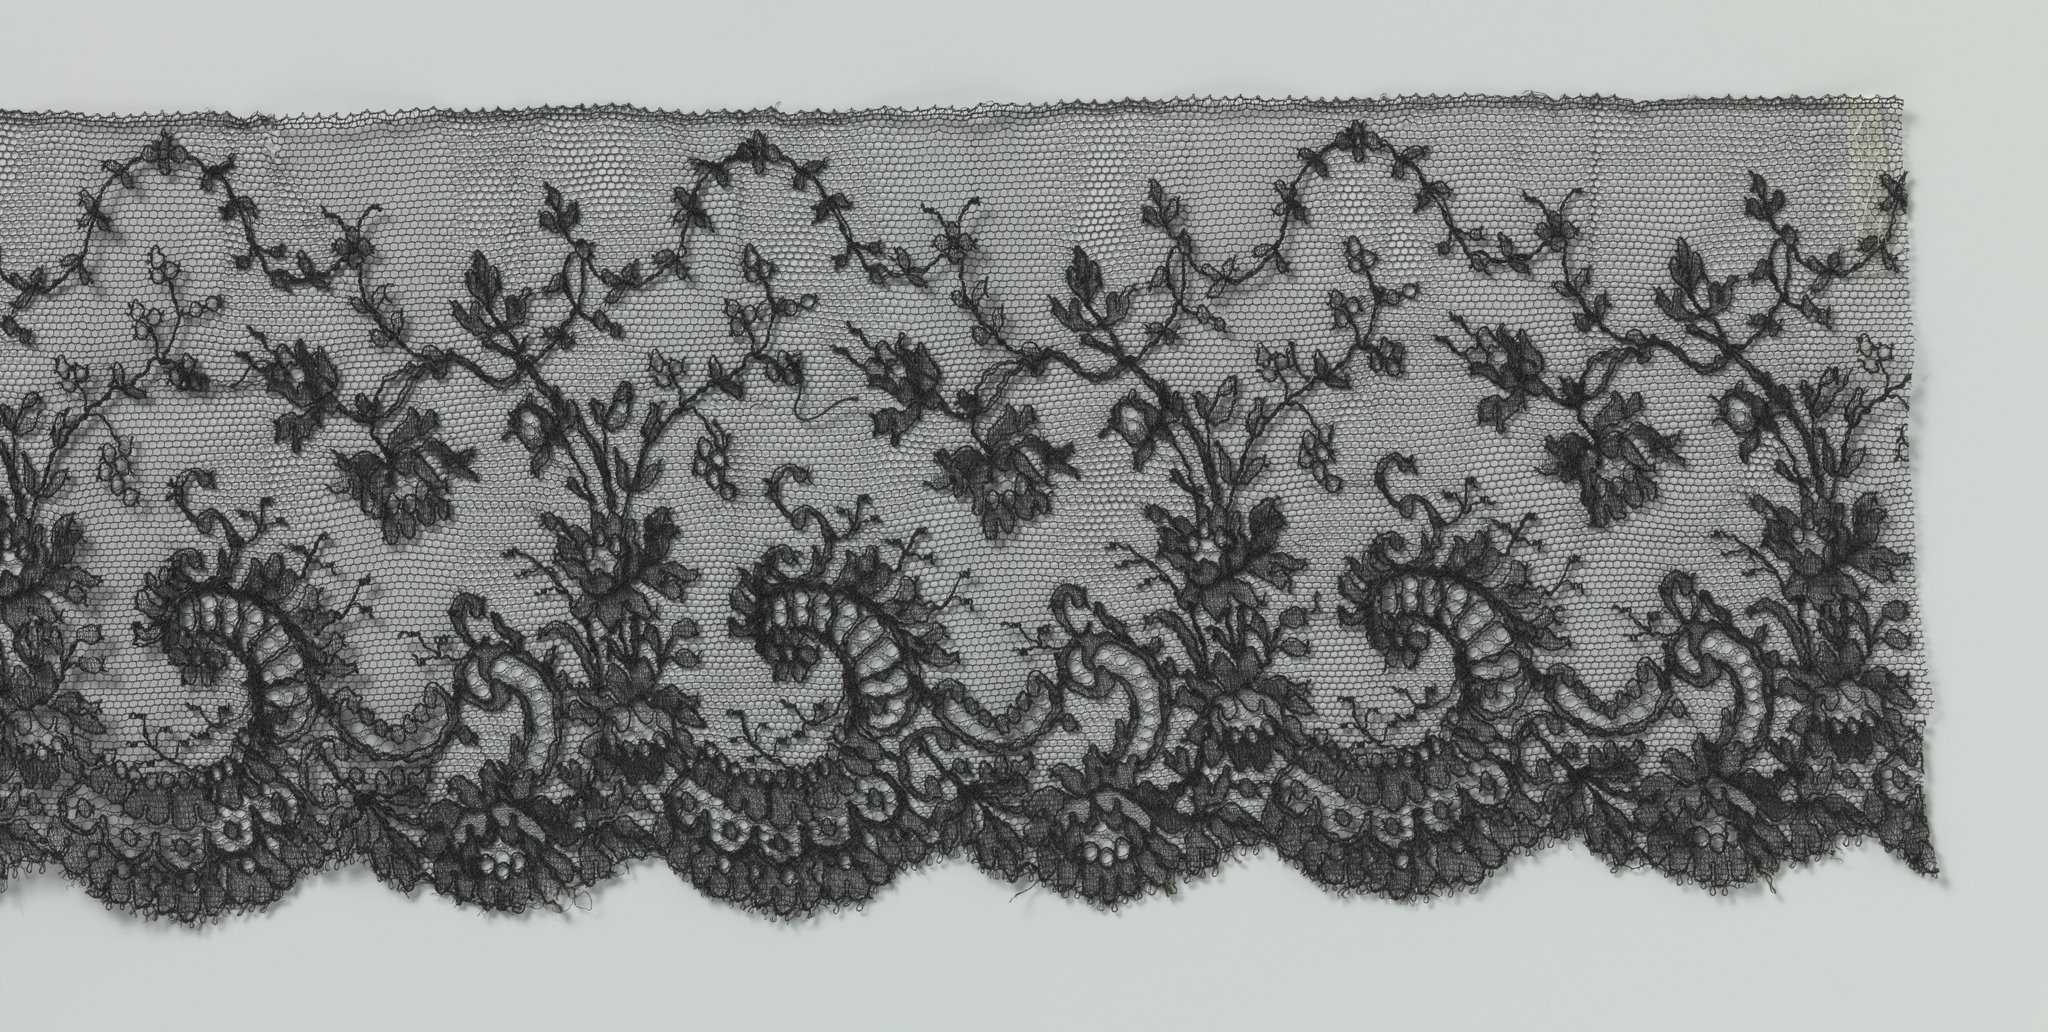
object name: strip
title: Strook machinale kant met rozentakken tussen c-voluten langs de onderzijde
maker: Anonymous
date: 1885-1899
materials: cotton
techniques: lace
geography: calais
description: Strook machinale kant: machinale Chantilly-kant. Het zich herhalende patroon langs de onderzijde van de strook bestaat uit c-voluten waartussen rozentakken ontspringen. De takken oversnijden deels een ijle bladslinger die zich langs de bovenzijde van de strook beweegt met boogjes en lussen. De motieven zijn voorzien van contourdraden en zijn met elkaar verbonden door een machinale tulegrond. In de motieven zijn siergronden toegepast. De schulpenrand langs de onderzijde van de strook komt voort uit het patroon met de c-voluten en is afgewerkt met picots. De bovenzijde van de strook is recht afgewerkt.